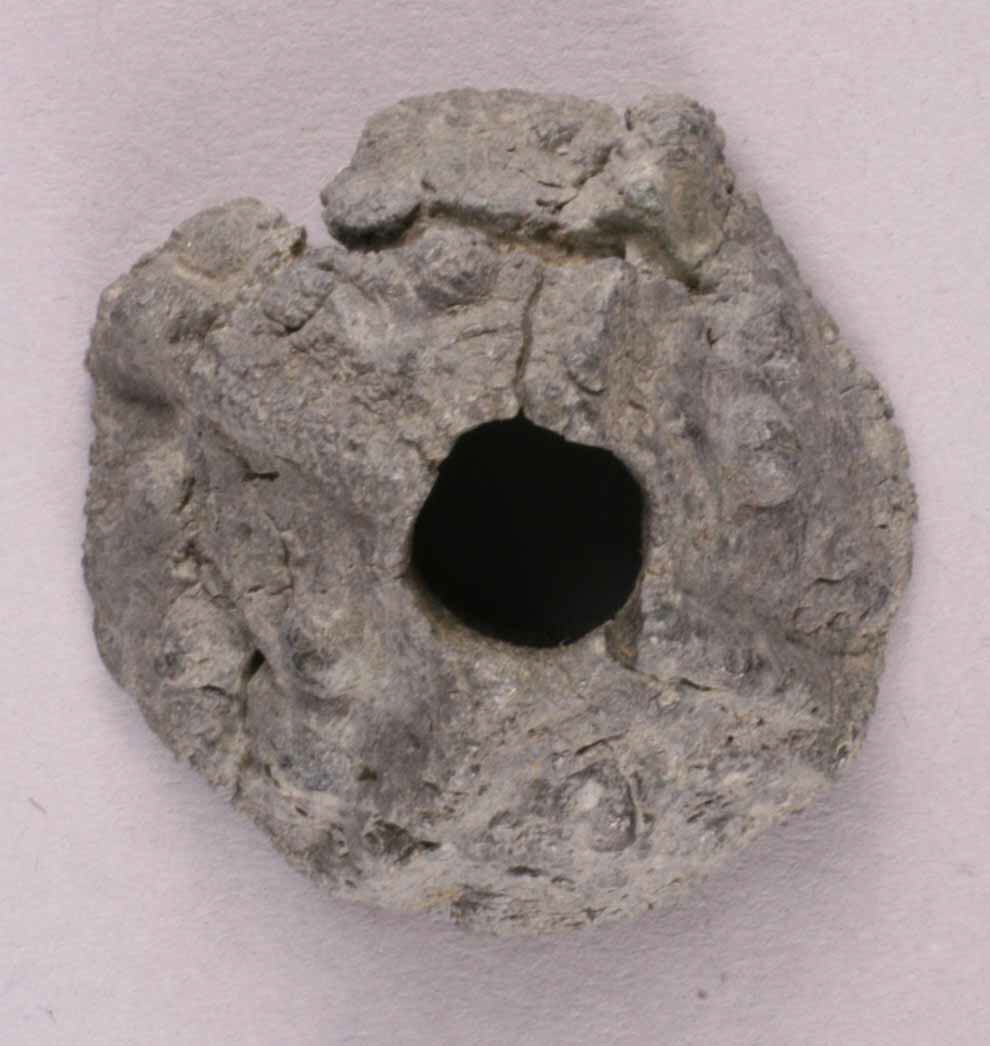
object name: weight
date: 801-1000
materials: lead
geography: iran